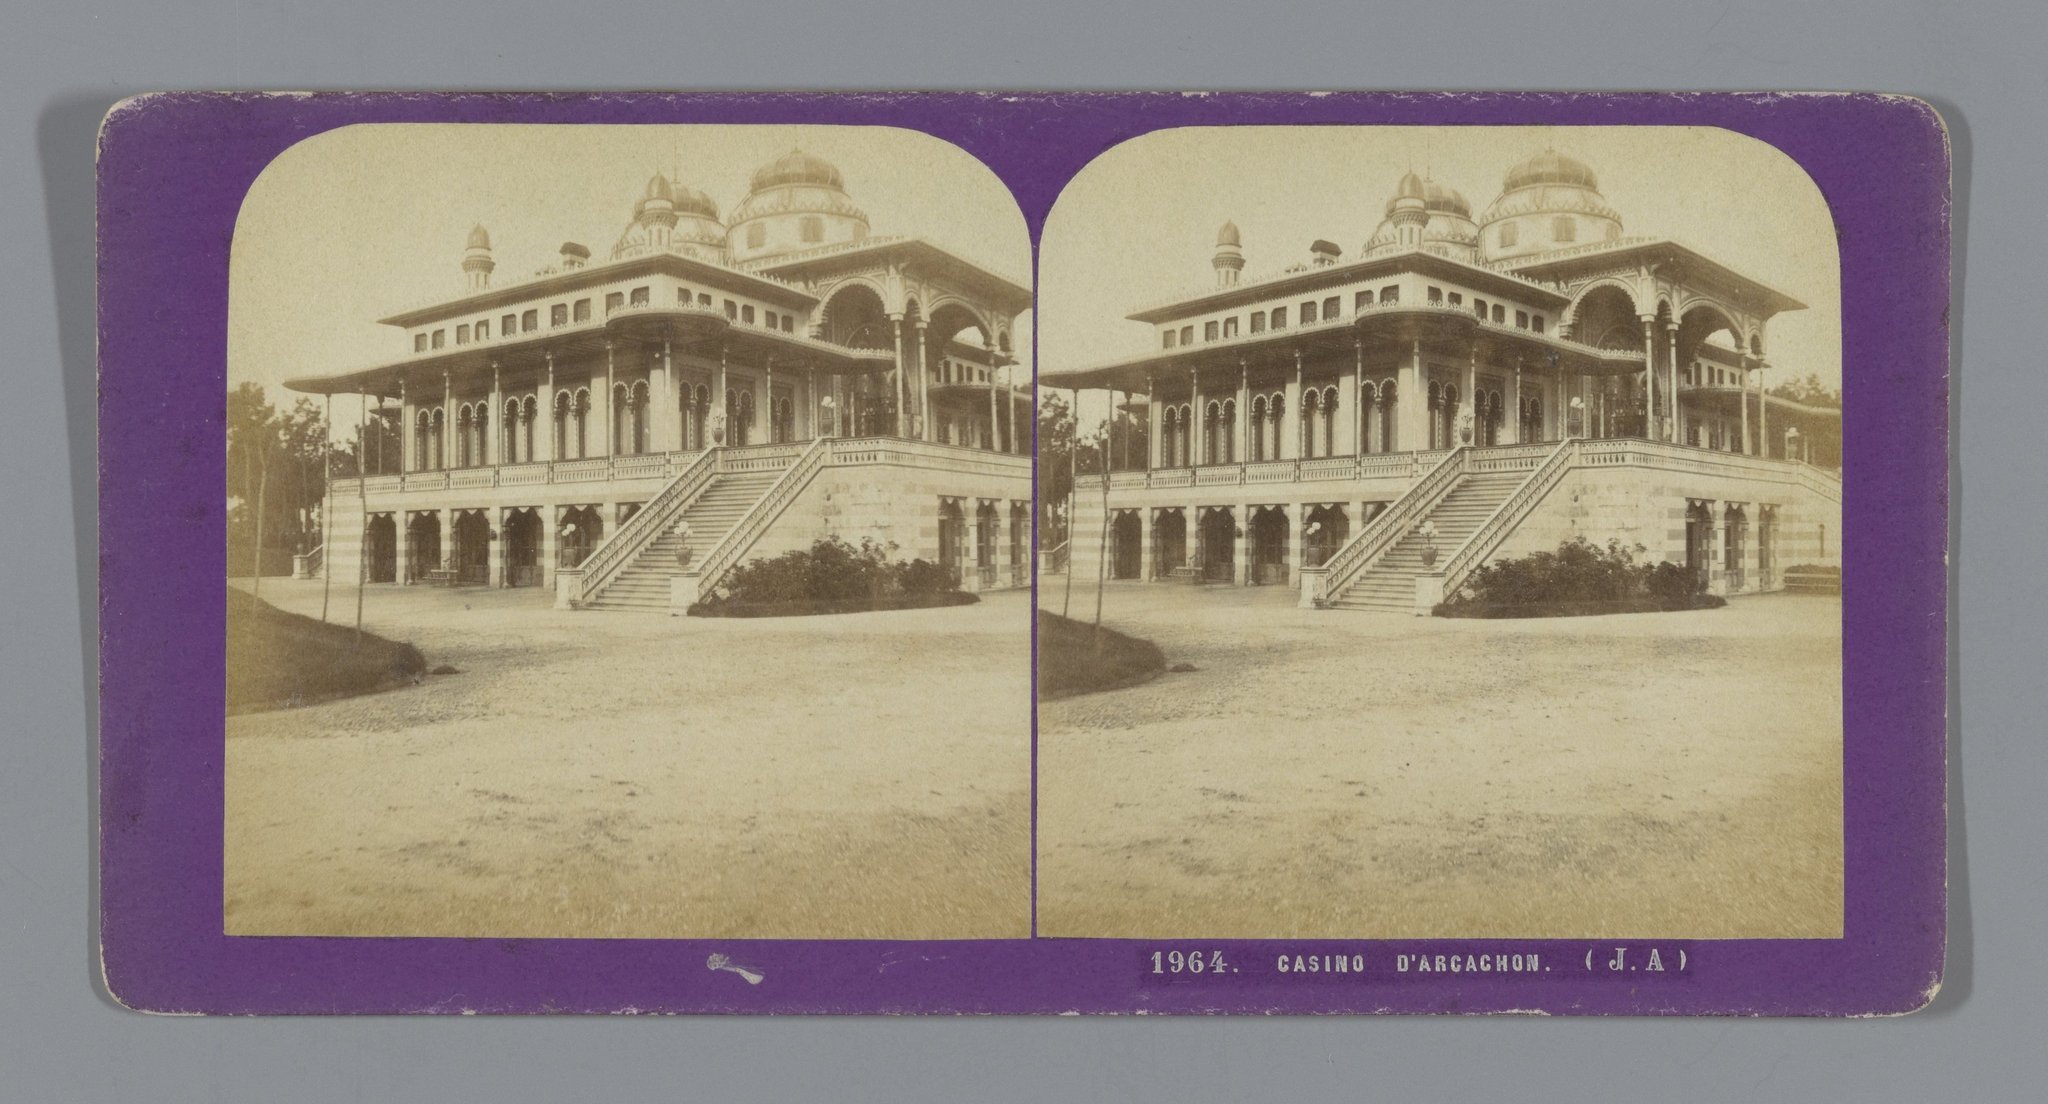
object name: stereograph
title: Exterieur van Casino Mauresque te Arcachon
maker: jean andrieu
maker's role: fotograaf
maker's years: 1816-1872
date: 1862-1876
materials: cardboard, photographic support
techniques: albumen print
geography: arcachon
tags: casino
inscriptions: number: ‘1964.’